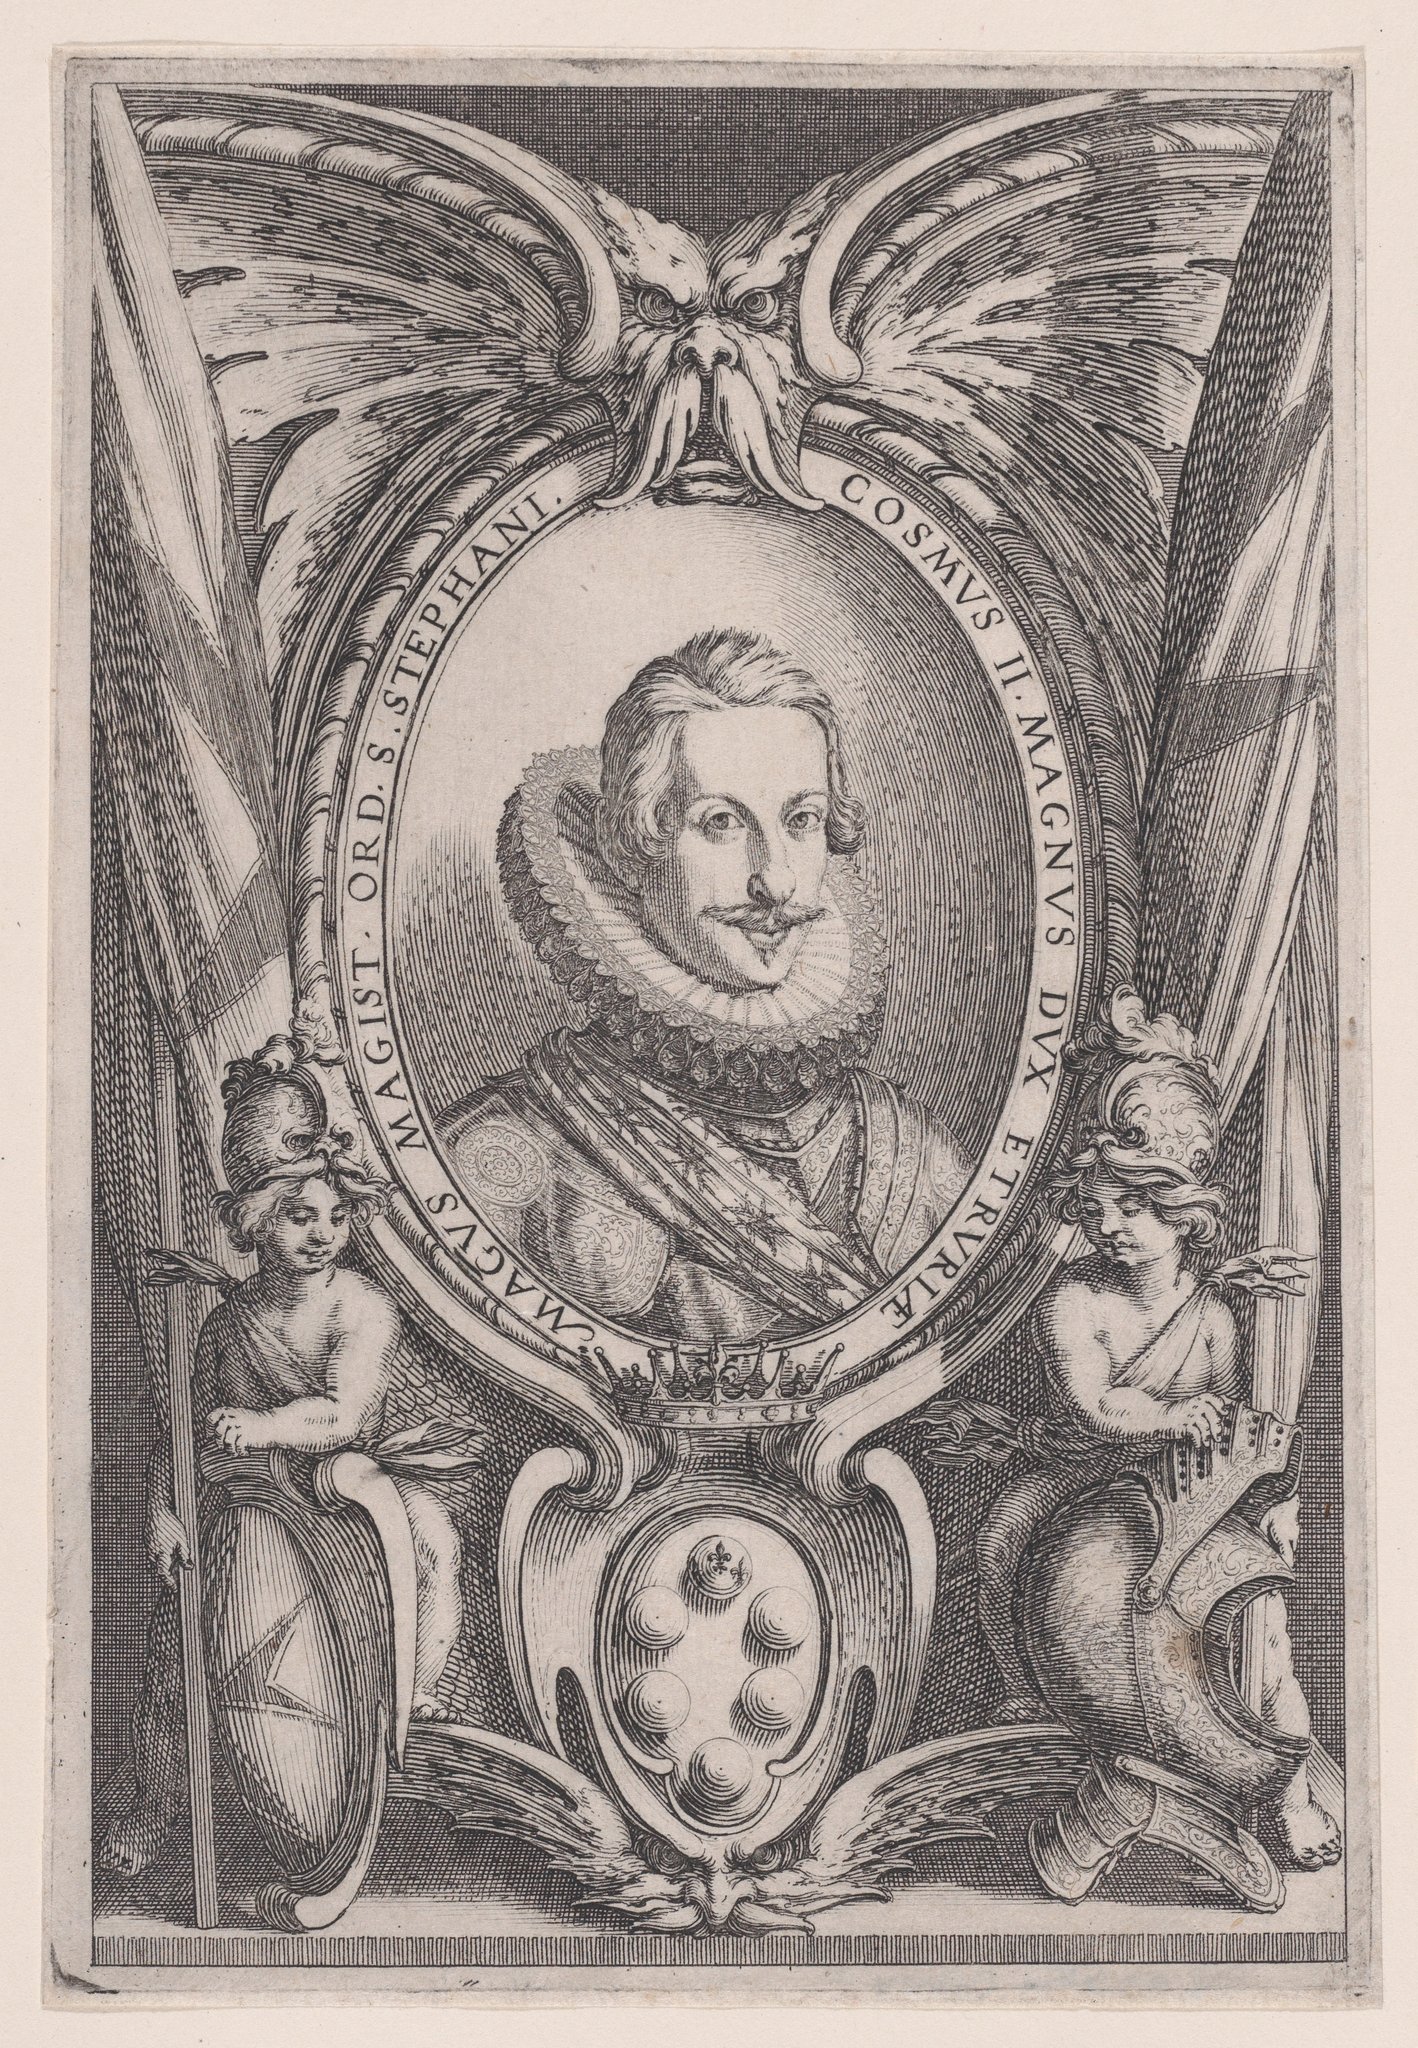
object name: print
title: Portrait de Cosme II, Grand Duc de Toscane (Portrait of Cosimo II, Grand Duke of Tuscany)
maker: jacques callot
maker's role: artist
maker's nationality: french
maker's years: 1592-1635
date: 1620-1621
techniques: engraving, etching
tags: men,portraits,coat of arms